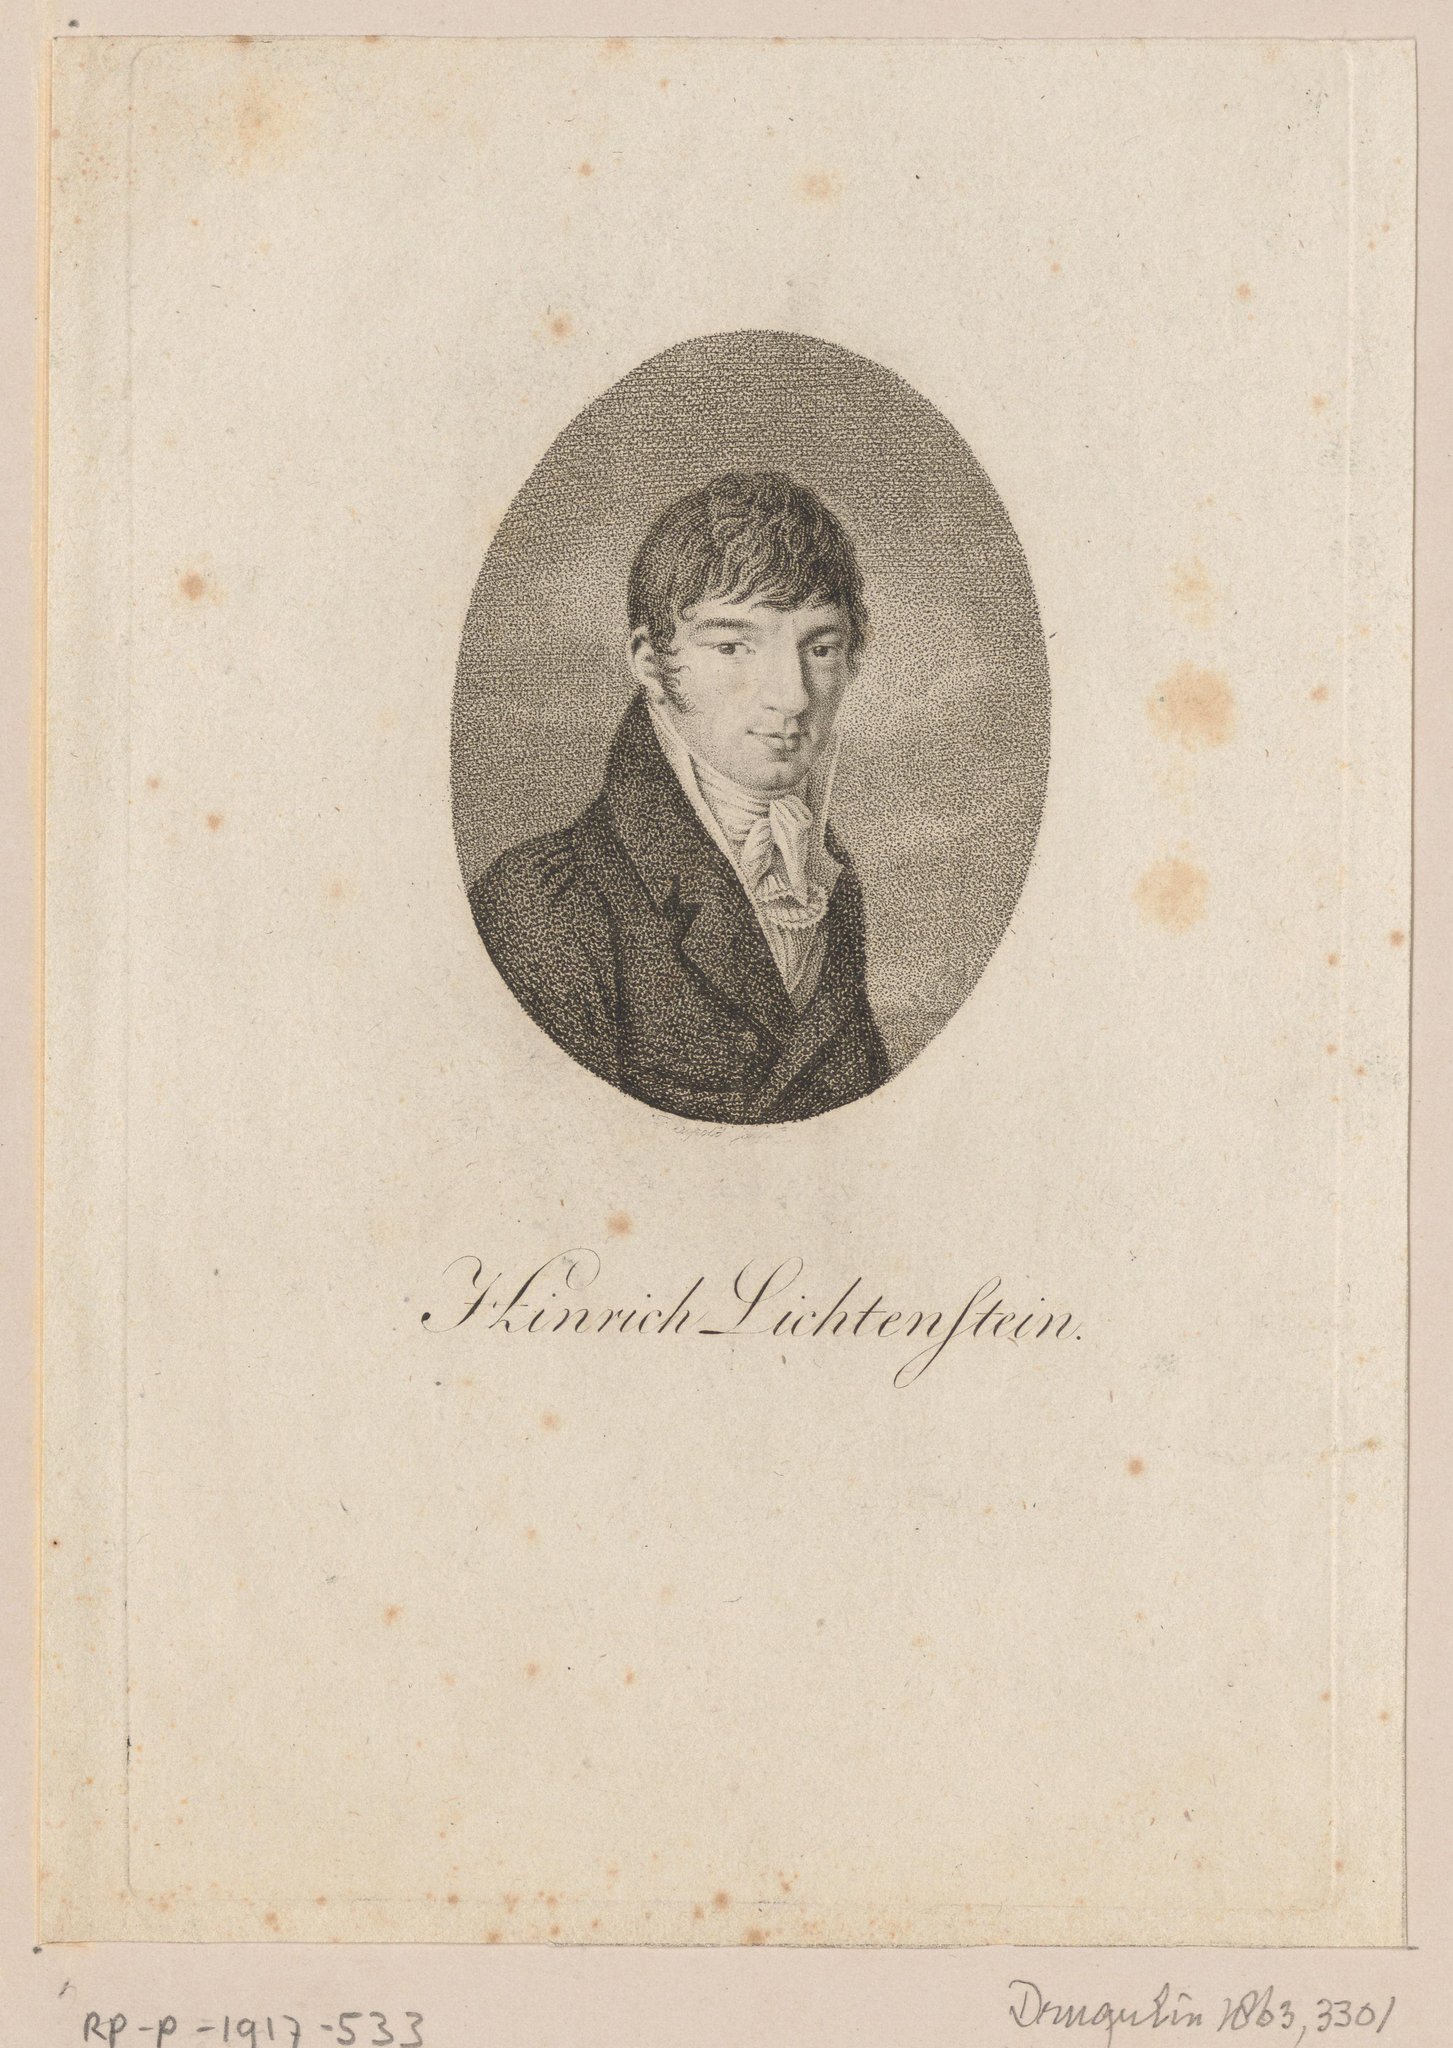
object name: print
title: Portret van Martin Hinrich Lichtenstein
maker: franz joseph leopold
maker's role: print maker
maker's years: 1783-1832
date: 1800-1832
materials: paper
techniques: stippling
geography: germany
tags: zoology (+ portrait of scholar, scientist), historical persons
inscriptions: collector's mark: Lugt 2228